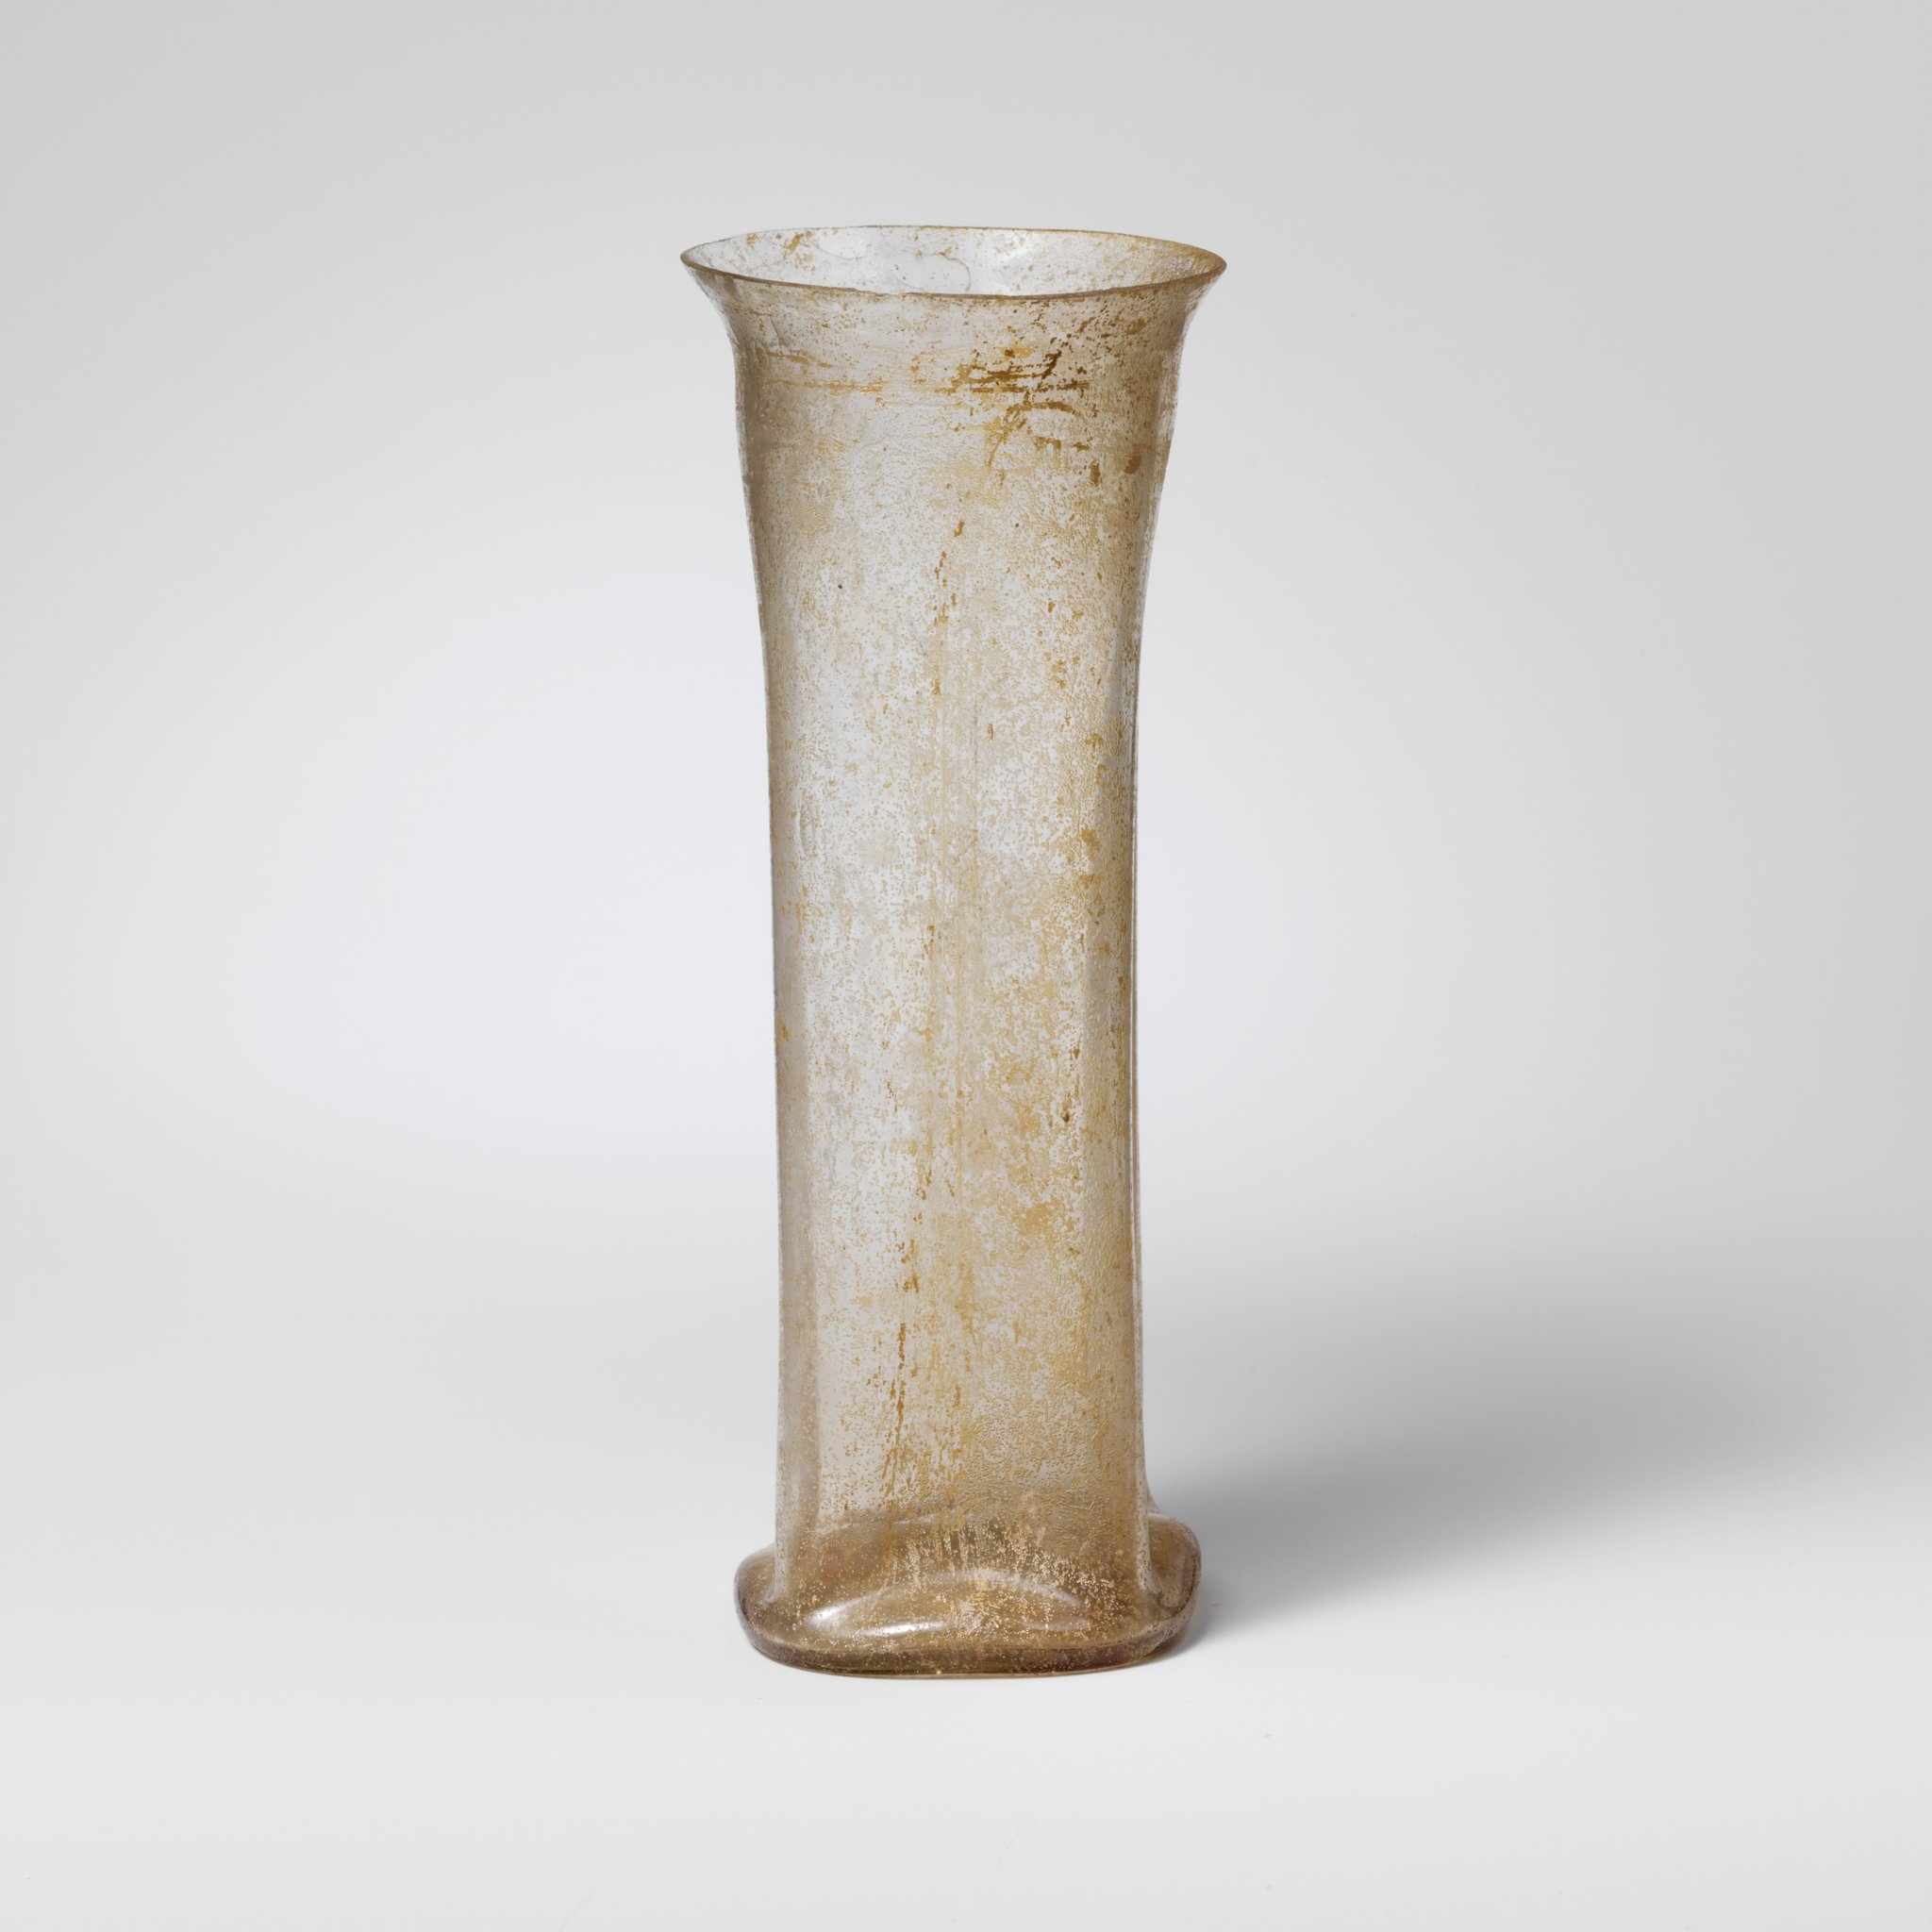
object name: beaker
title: Glass beaker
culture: roman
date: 101-300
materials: glass